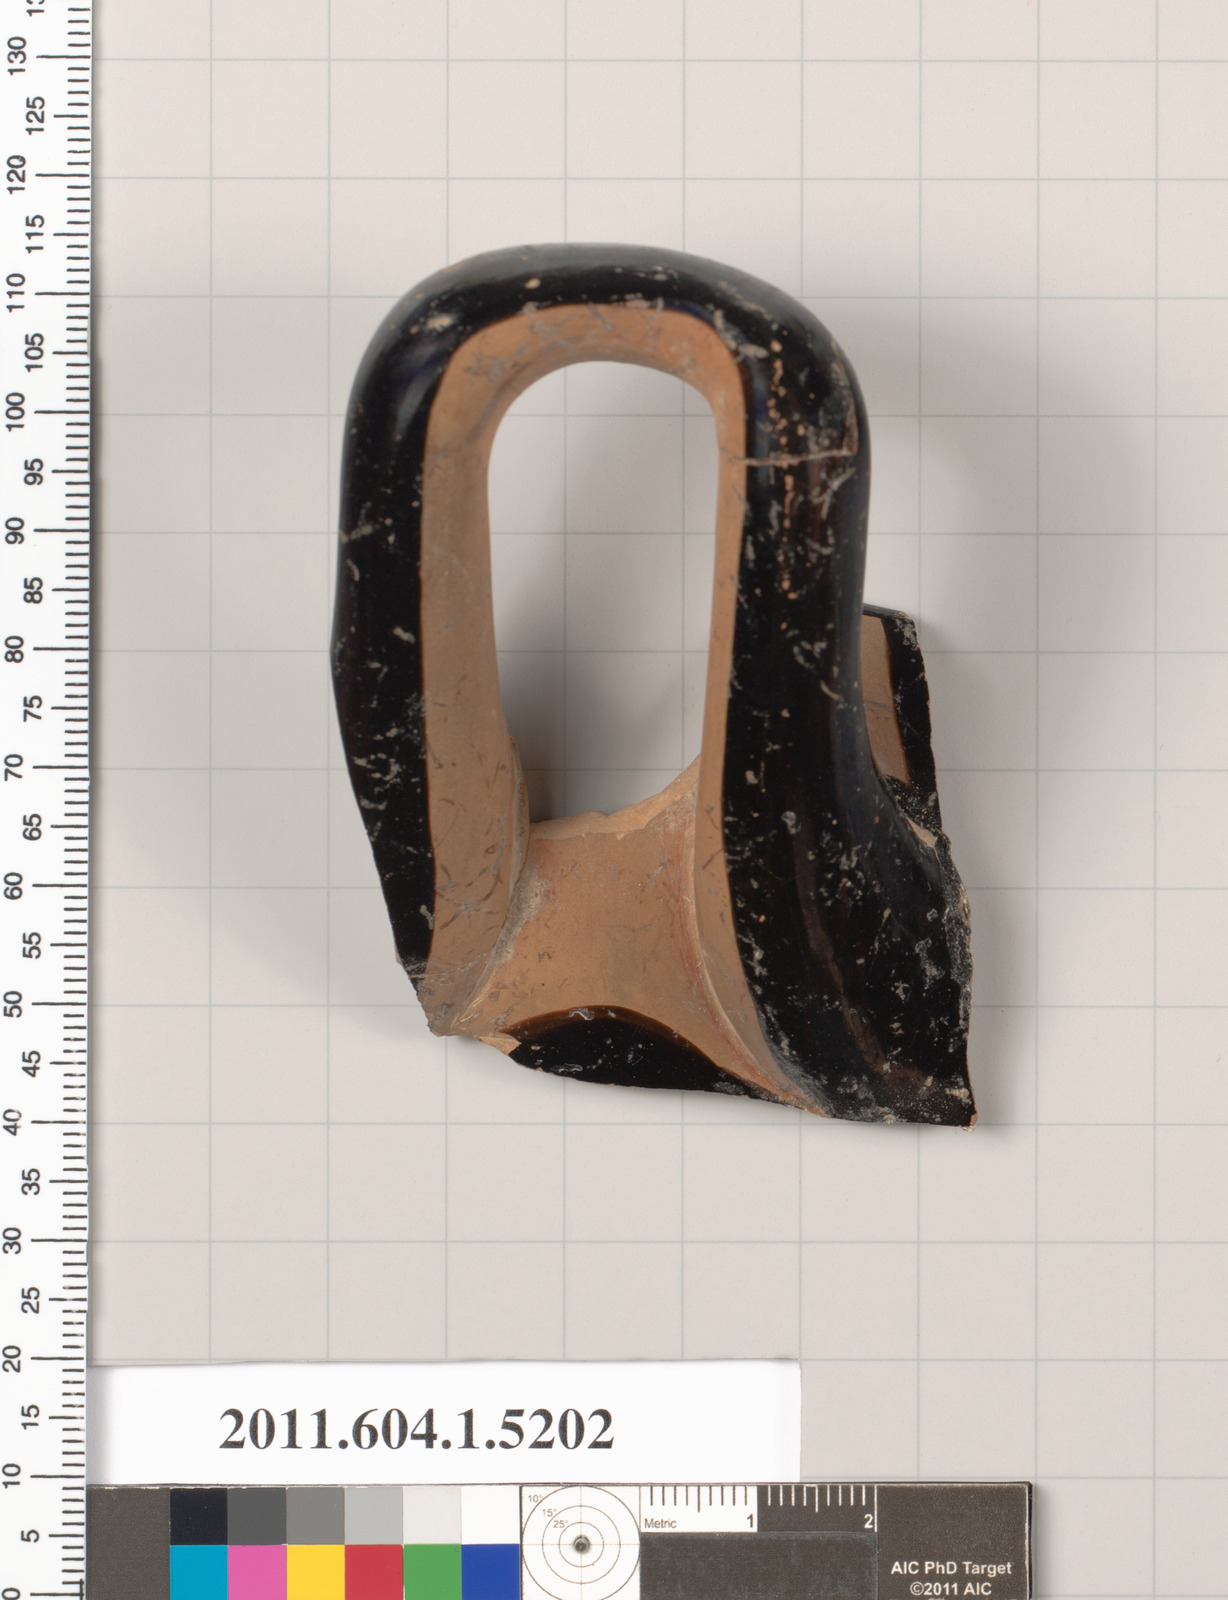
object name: kylix fragment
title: Terracotta fragment of a kylix (drinking cup)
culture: greek, attic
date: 500-476 BCE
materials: terracotta